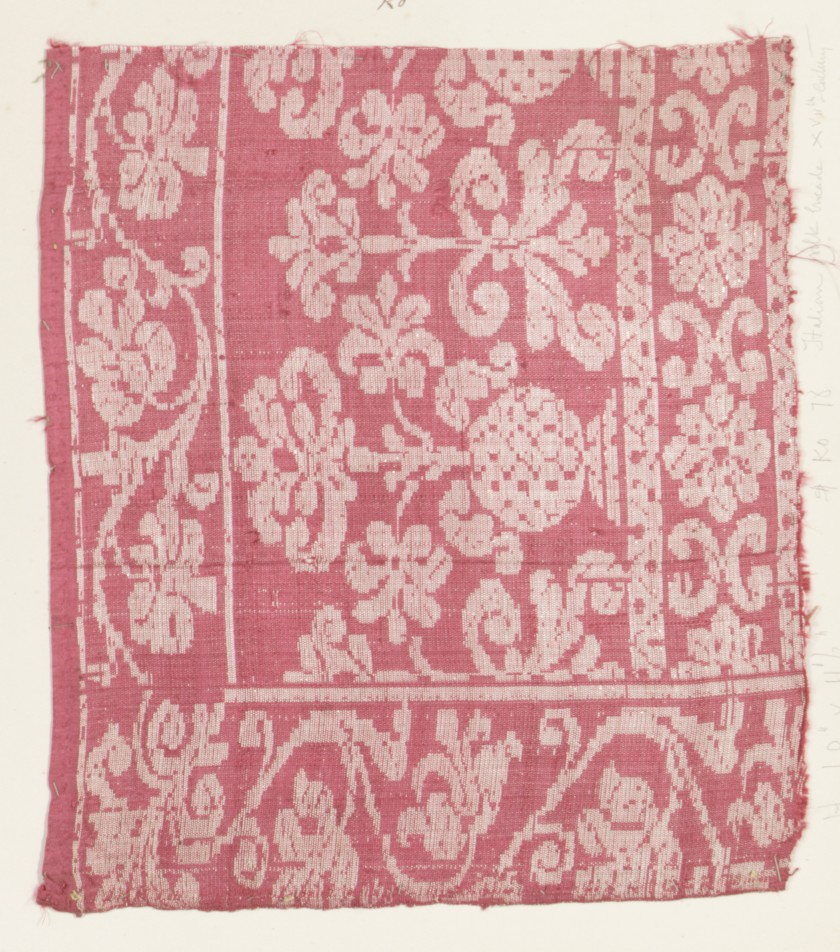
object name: fragment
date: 1601-1700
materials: silk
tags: flowers